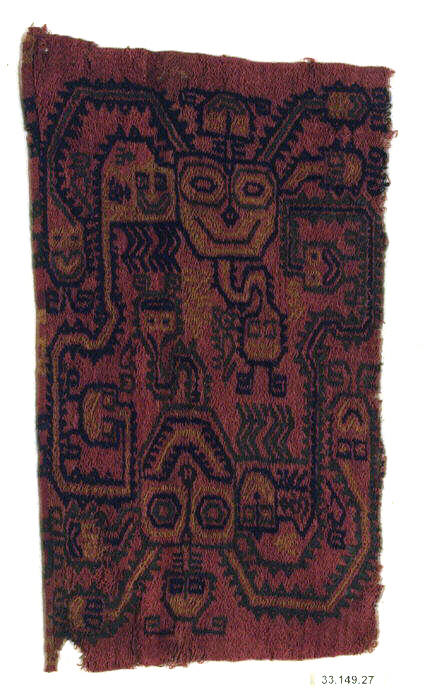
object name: border fragment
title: Embroidered Border Fragment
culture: paracas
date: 500-201 BCE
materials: animal fiber, cotton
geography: peru